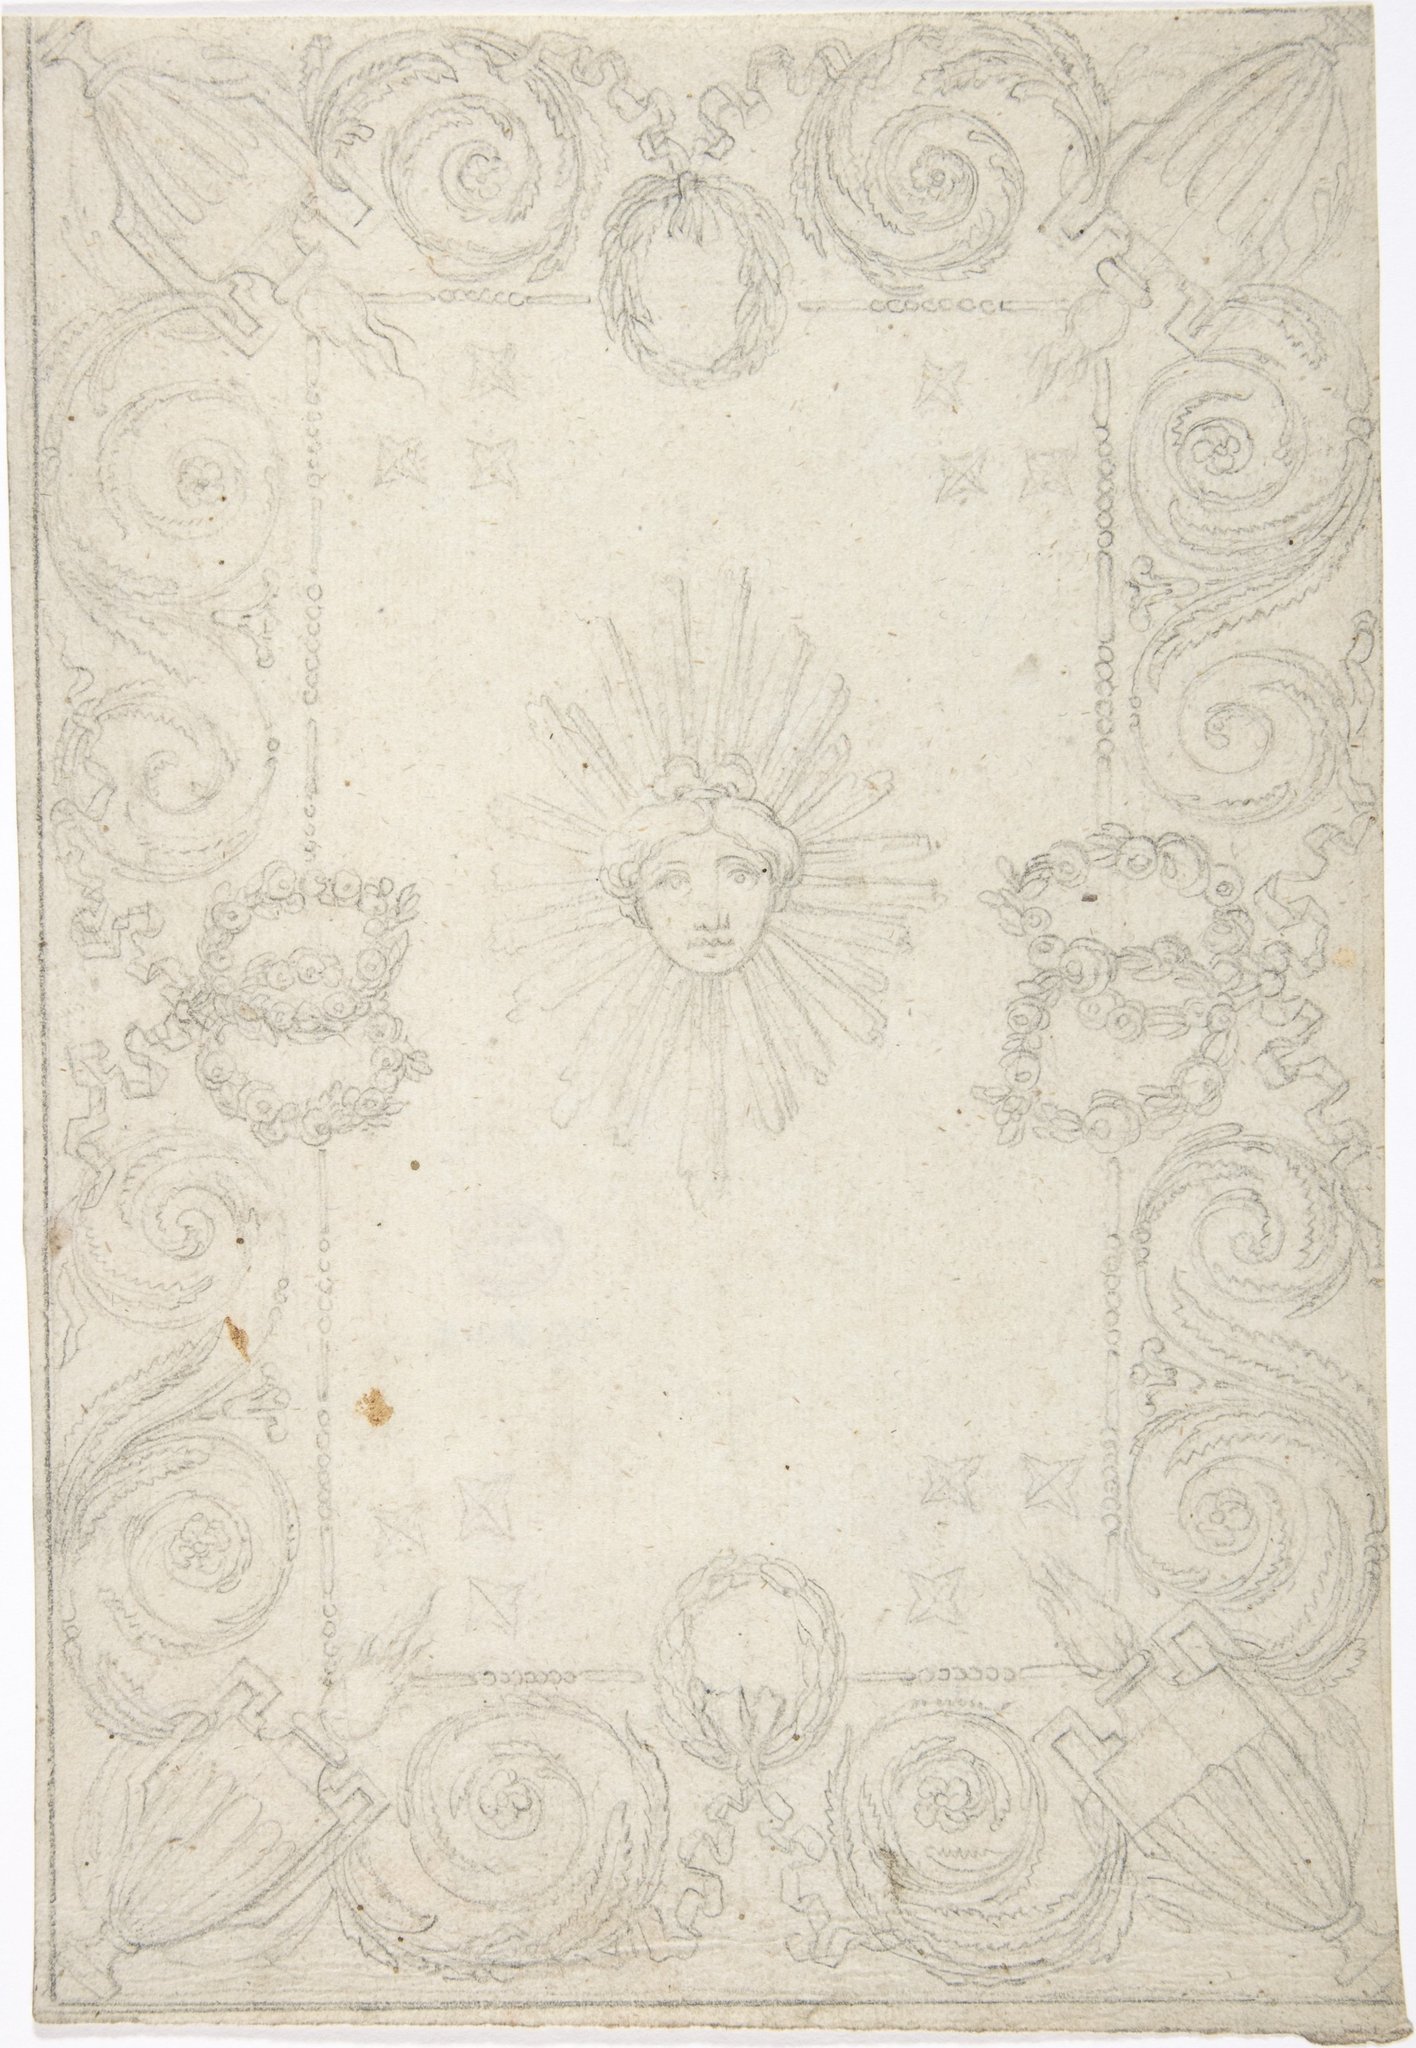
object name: drawing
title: Design for Ceiling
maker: anonymous, french, 18th century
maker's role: artist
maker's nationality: french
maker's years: 1700-1800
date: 1701-1800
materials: graphite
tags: garlands,faces